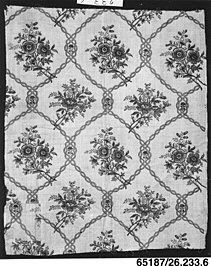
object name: floral print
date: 1778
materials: linen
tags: flowers